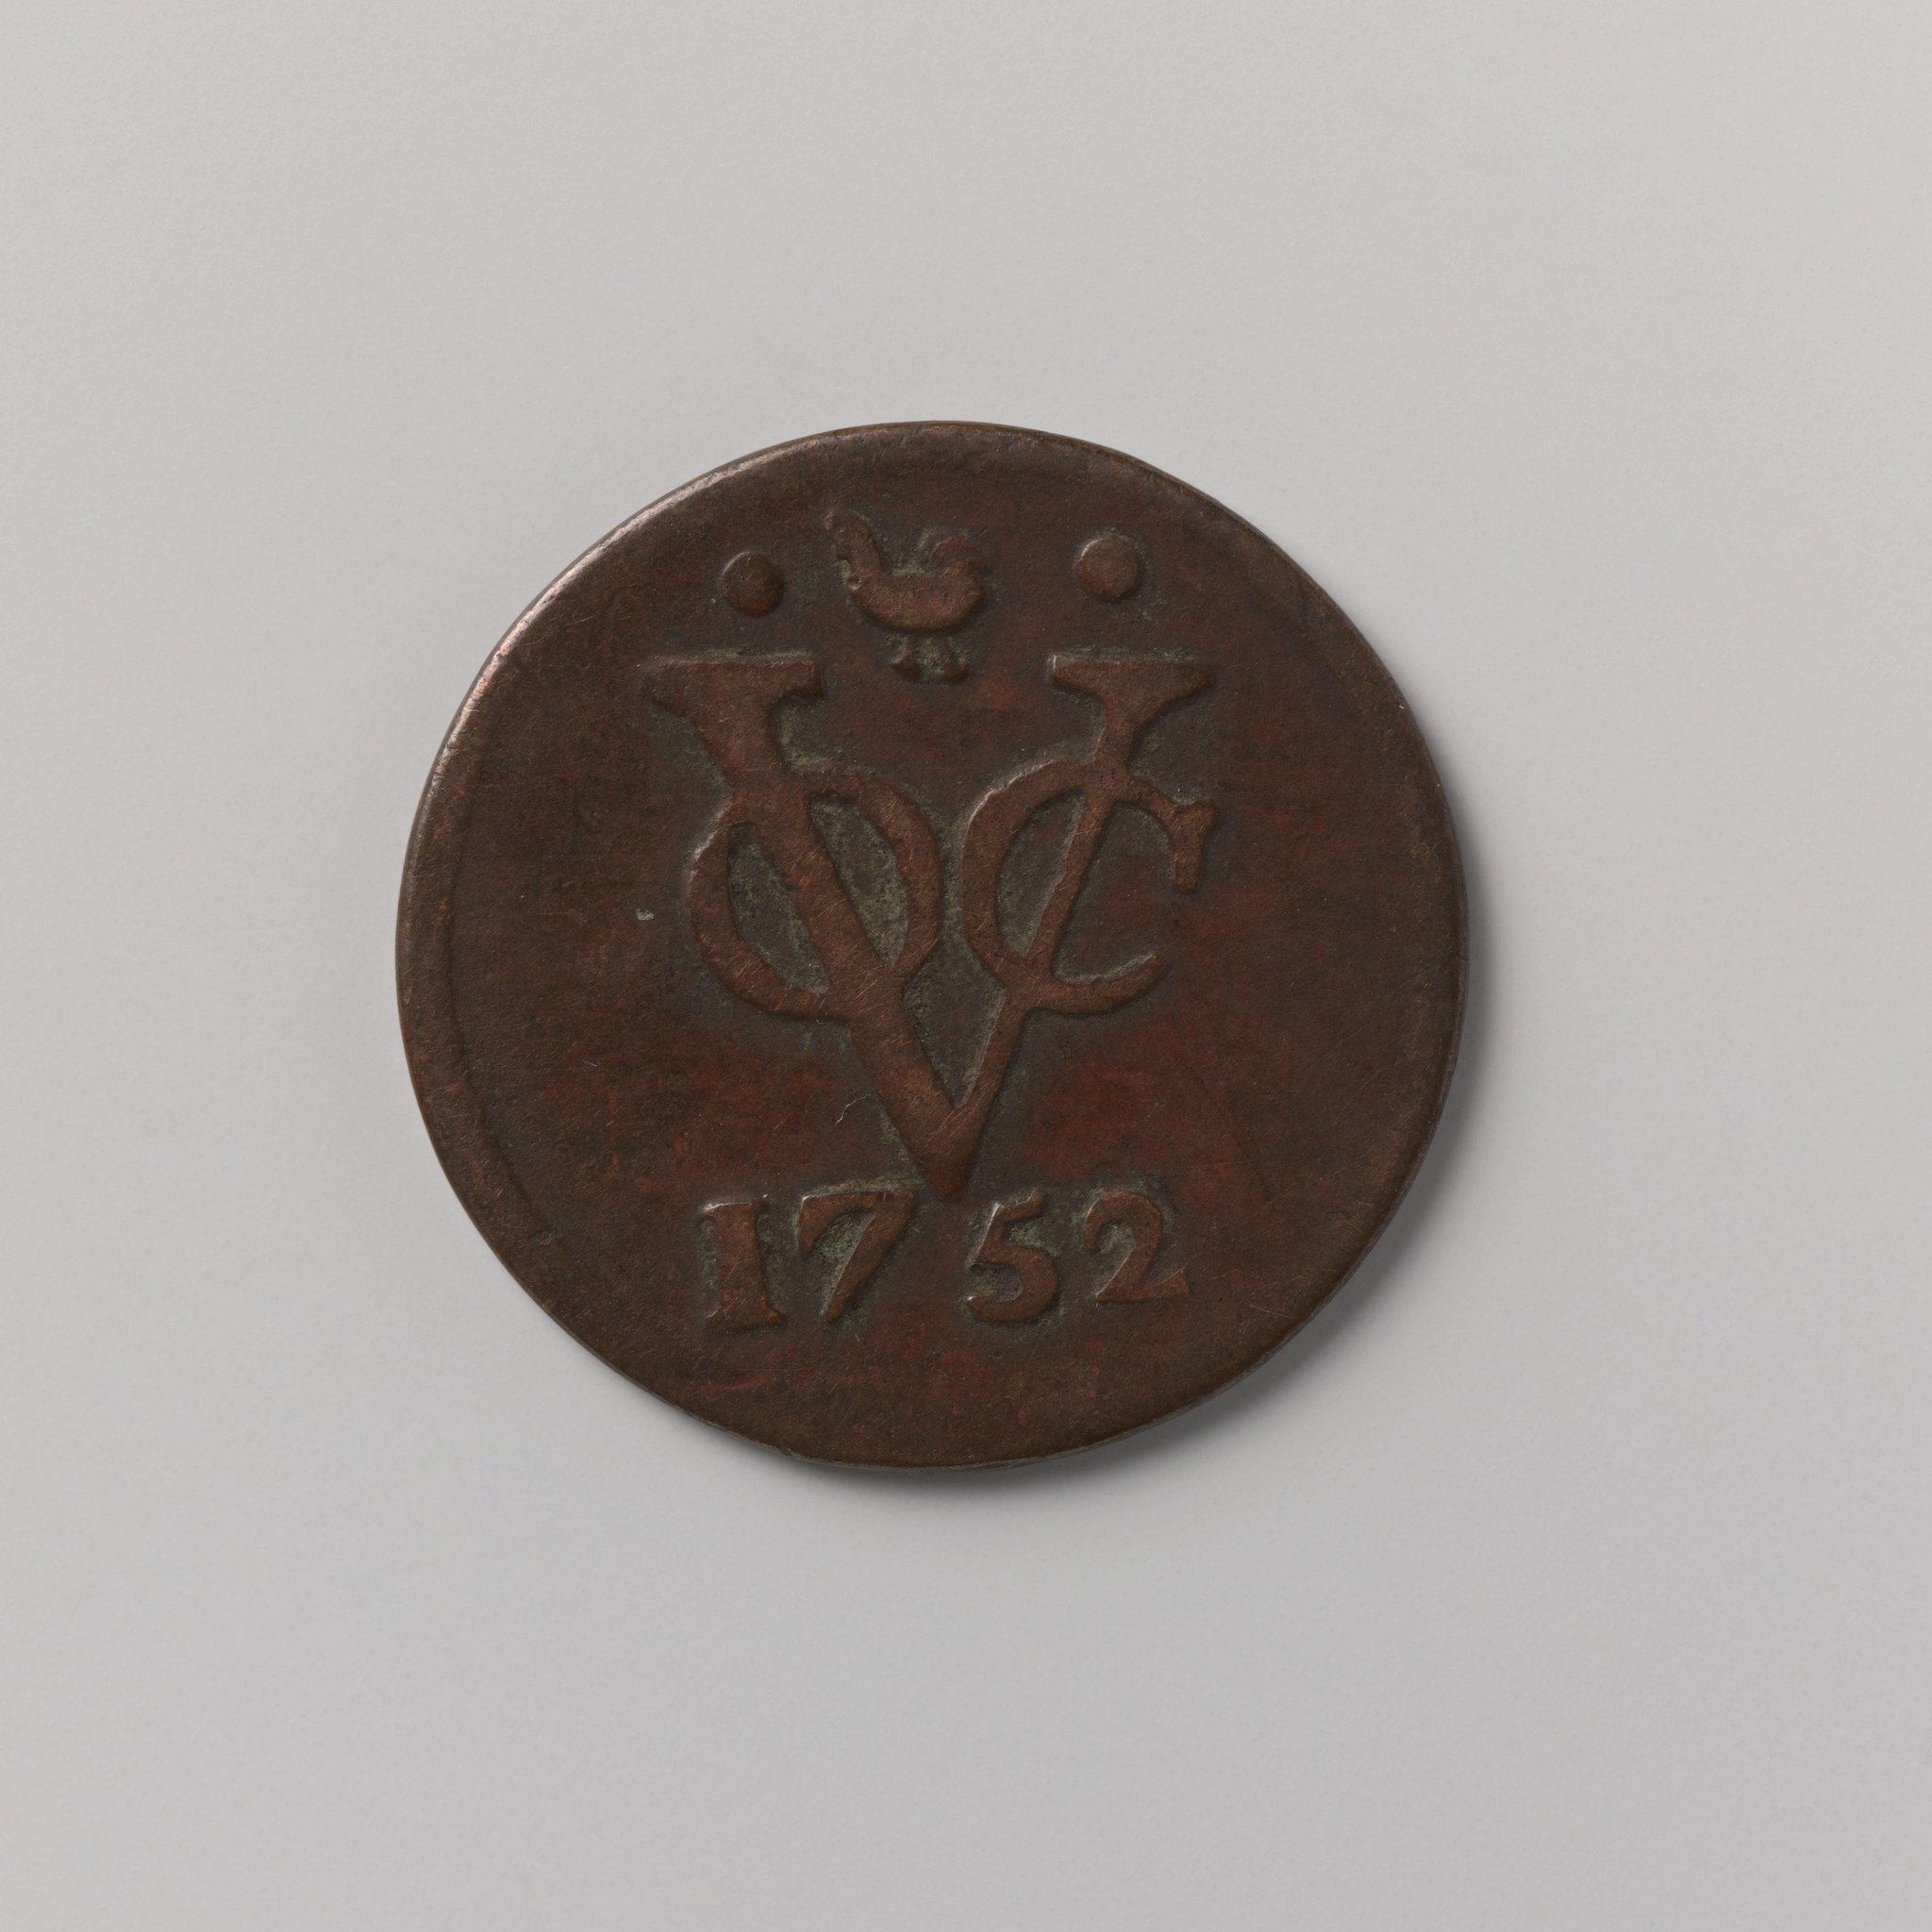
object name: coin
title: VOC, duit Westfriesland, 1752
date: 1752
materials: copper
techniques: striking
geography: hoorn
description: Koperen munt. Voorzijde: gekroond wapenschild van Westfriesland. Keerzijde: monogram van de VOC, waarboven muntmeesterteken en waaronder jaartal. Gladde rand.